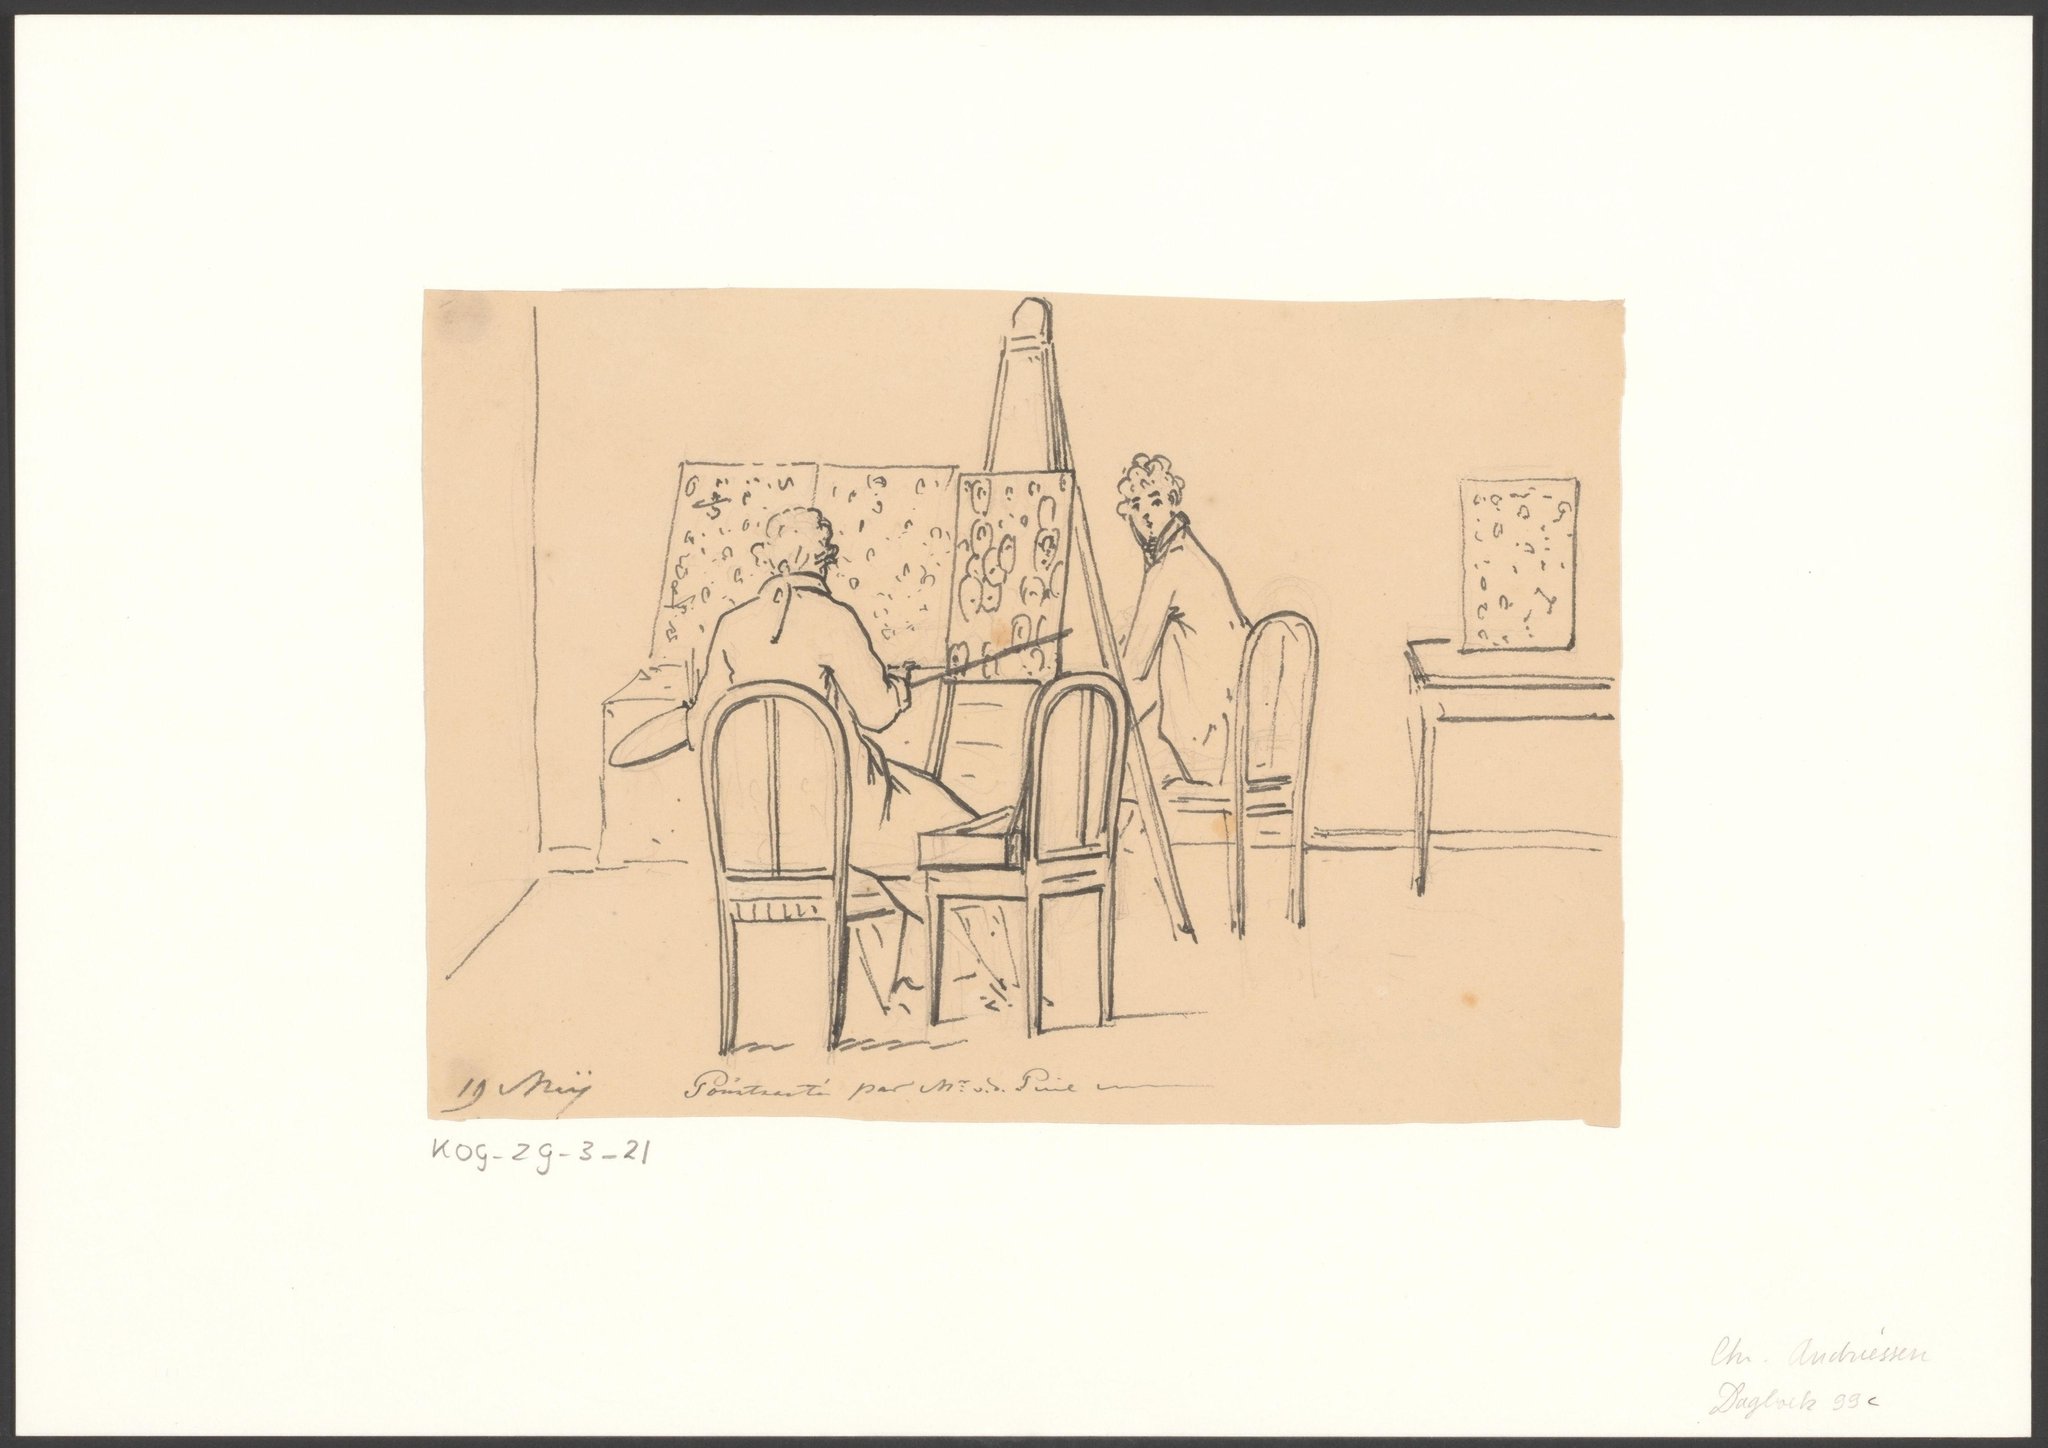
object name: drawing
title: Christiaan Andriessen schildert het portret van meneer du Puij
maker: christiaan andriessen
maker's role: draughtsman, print maker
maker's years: 1775-1846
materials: ink, paper, pencil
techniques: brush, pen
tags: window, glass of wine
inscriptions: inscription: ‘J Andriessen’, inscription: ‘19 meij Pourtraité par Mons du Puij’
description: Dagboekblad uit het getekende dagboek dat Christiaan Andriessen bijhield van 1805 tot en met 1808.